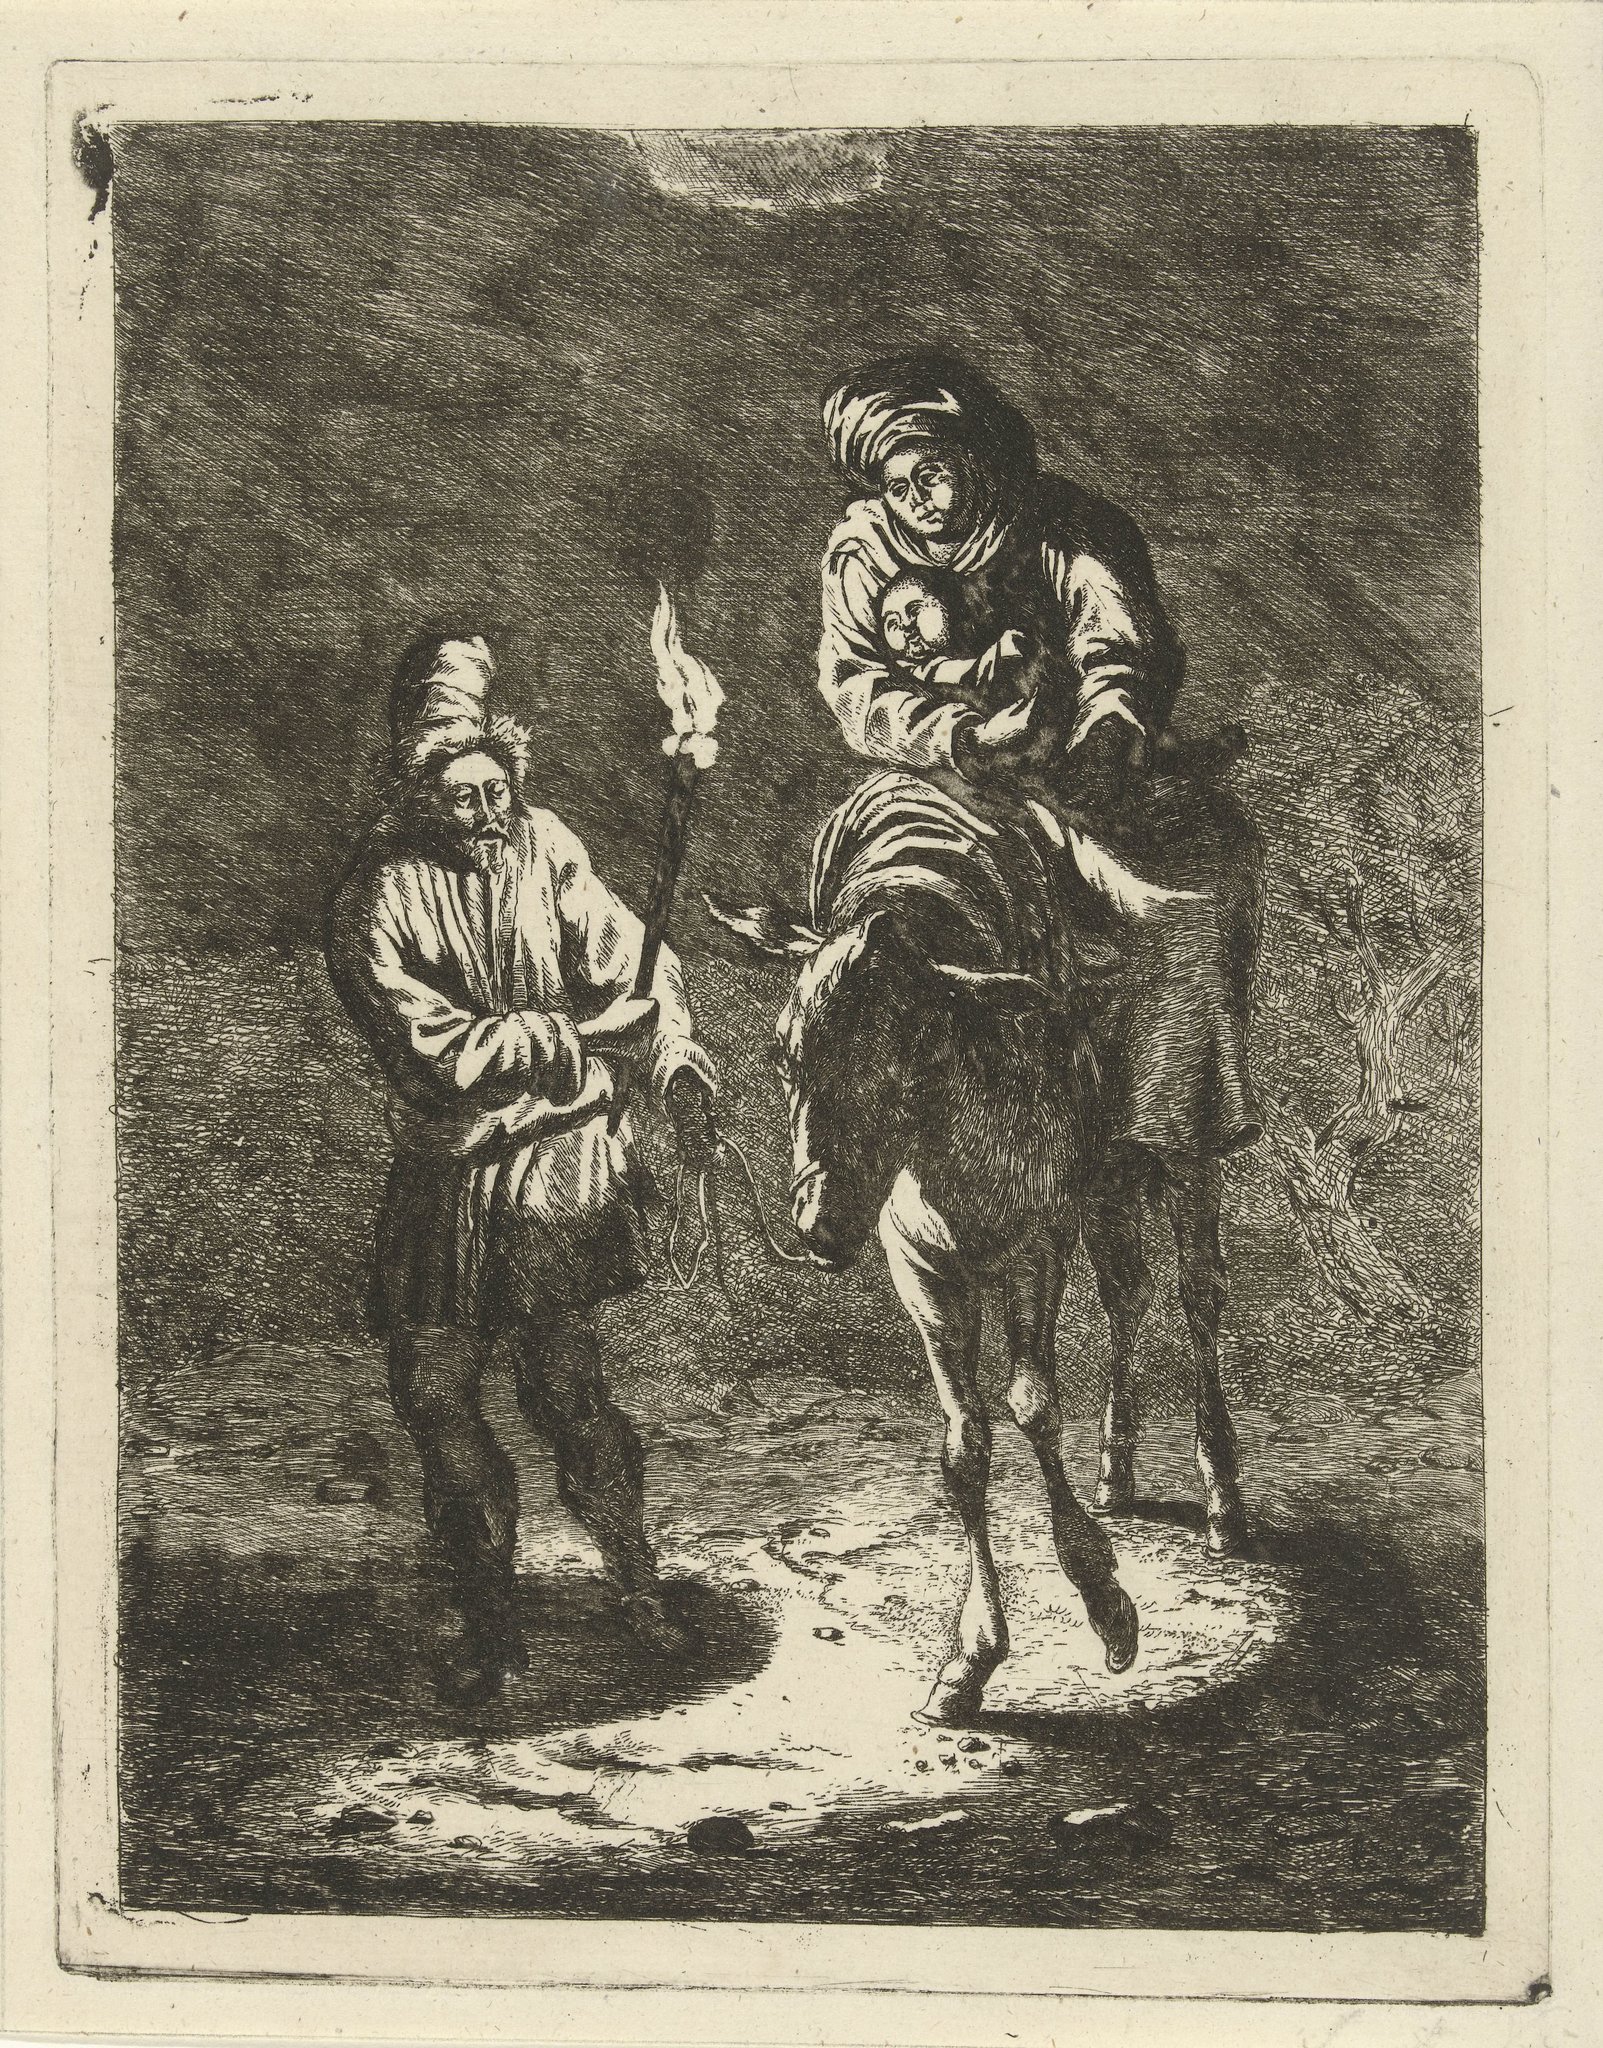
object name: print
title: Vlucht naar Egypte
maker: jabes heenck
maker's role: draughtsman, print maker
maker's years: 1752-1782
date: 1767-1782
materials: paper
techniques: etching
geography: northern netherlands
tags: torch, the flight into egypt: mary, joseph, the child (and sometimes others) on their way; mary usually riding on an ass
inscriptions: collector's mark: Lugt 2228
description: Rechts Maria met het Christuskind op de ezel; links loopt Jozef met in zijn rechterhand een fakkel.